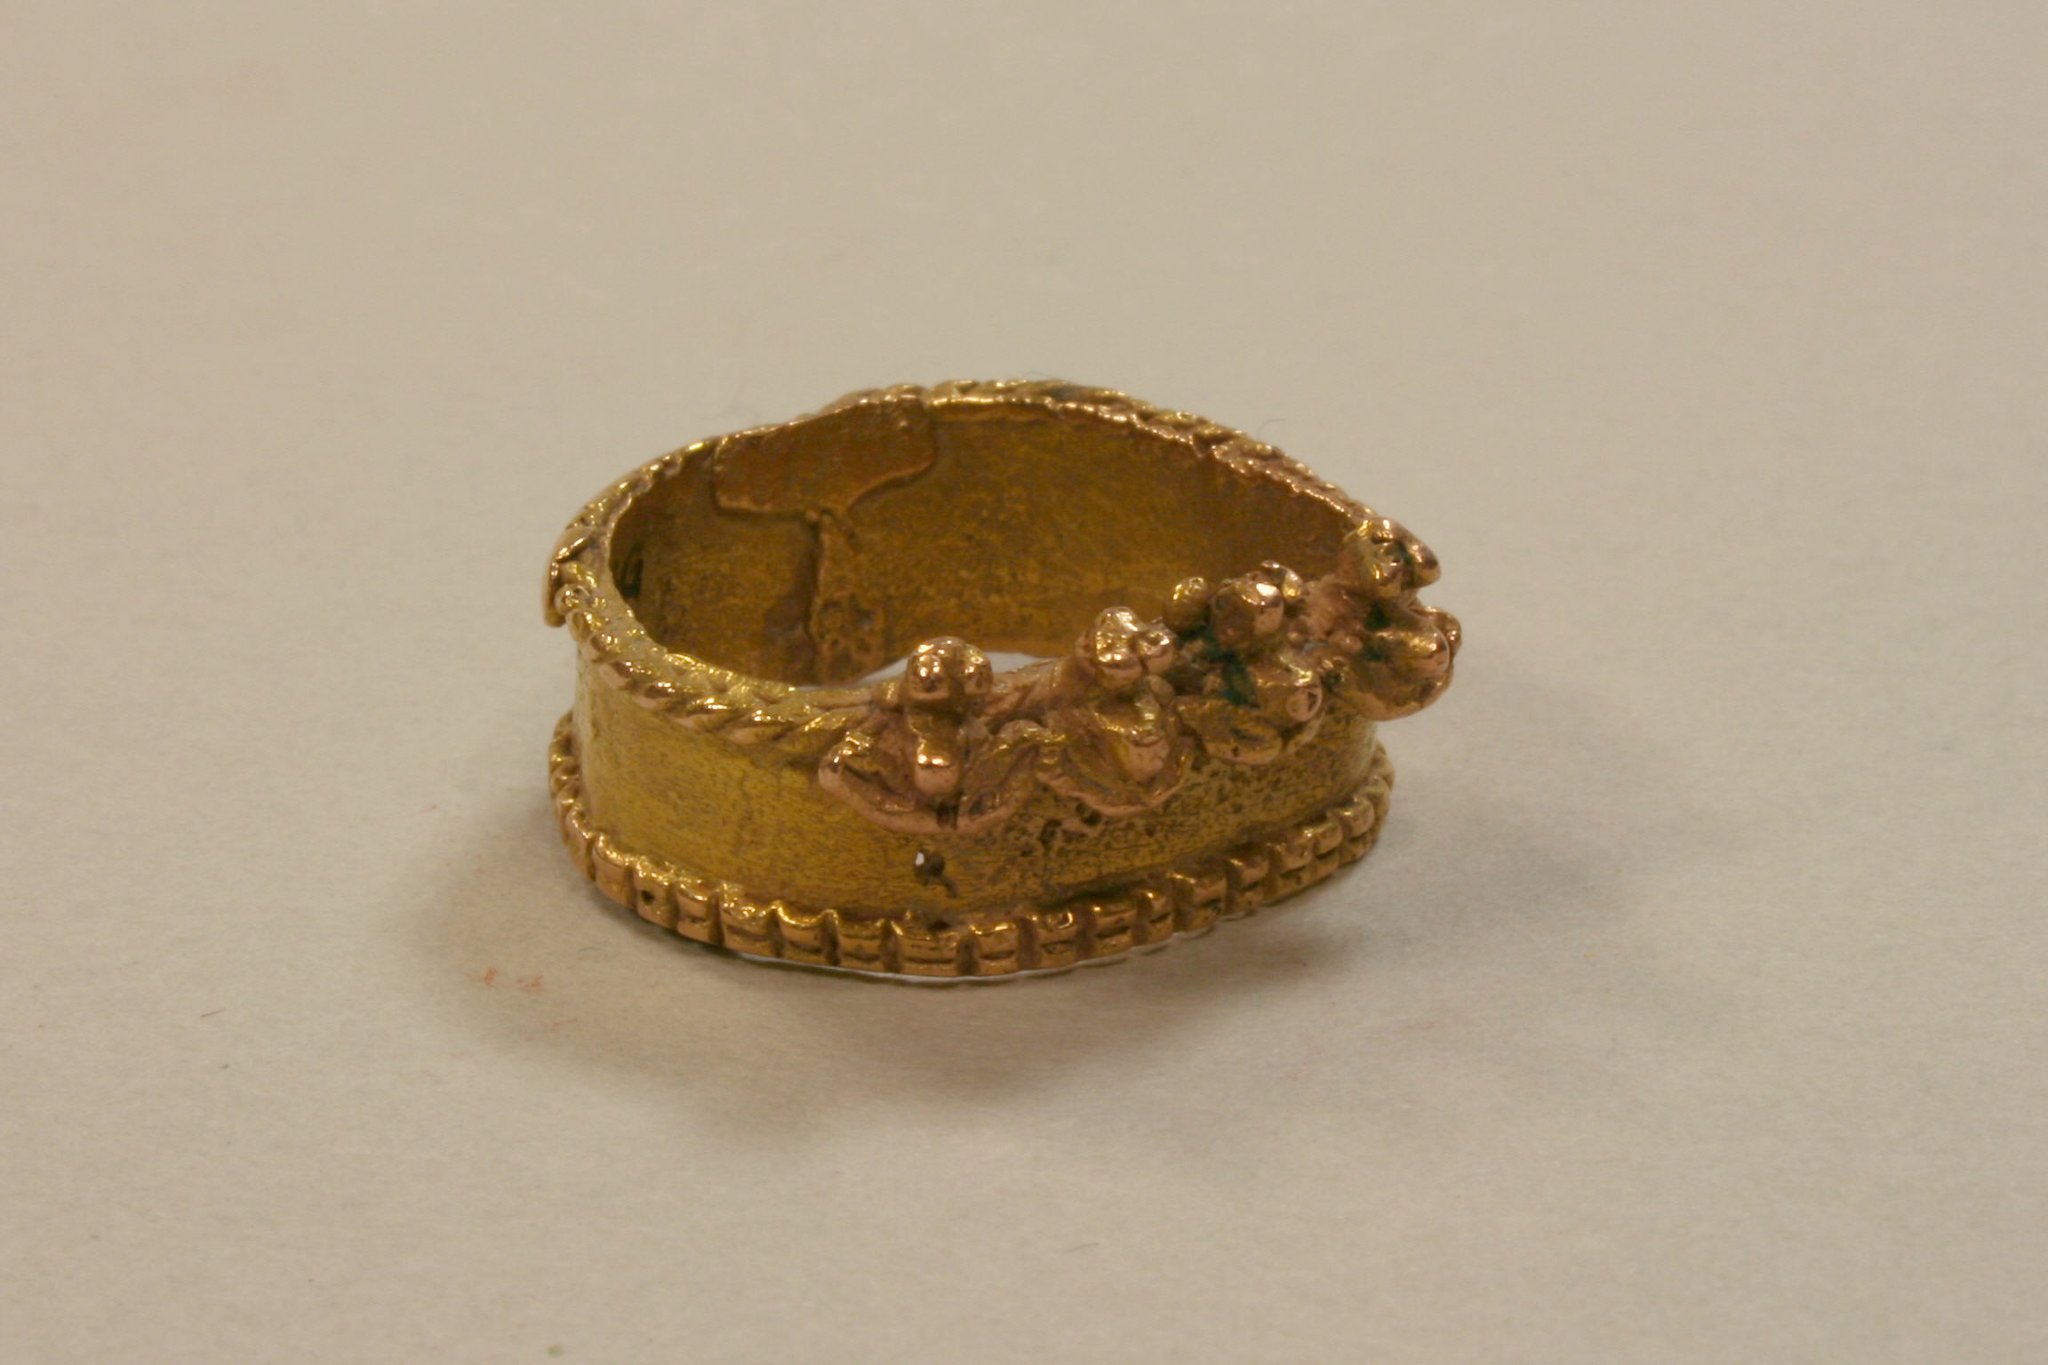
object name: ring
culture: coclé, parita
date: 1101-1400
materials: gold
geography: panama